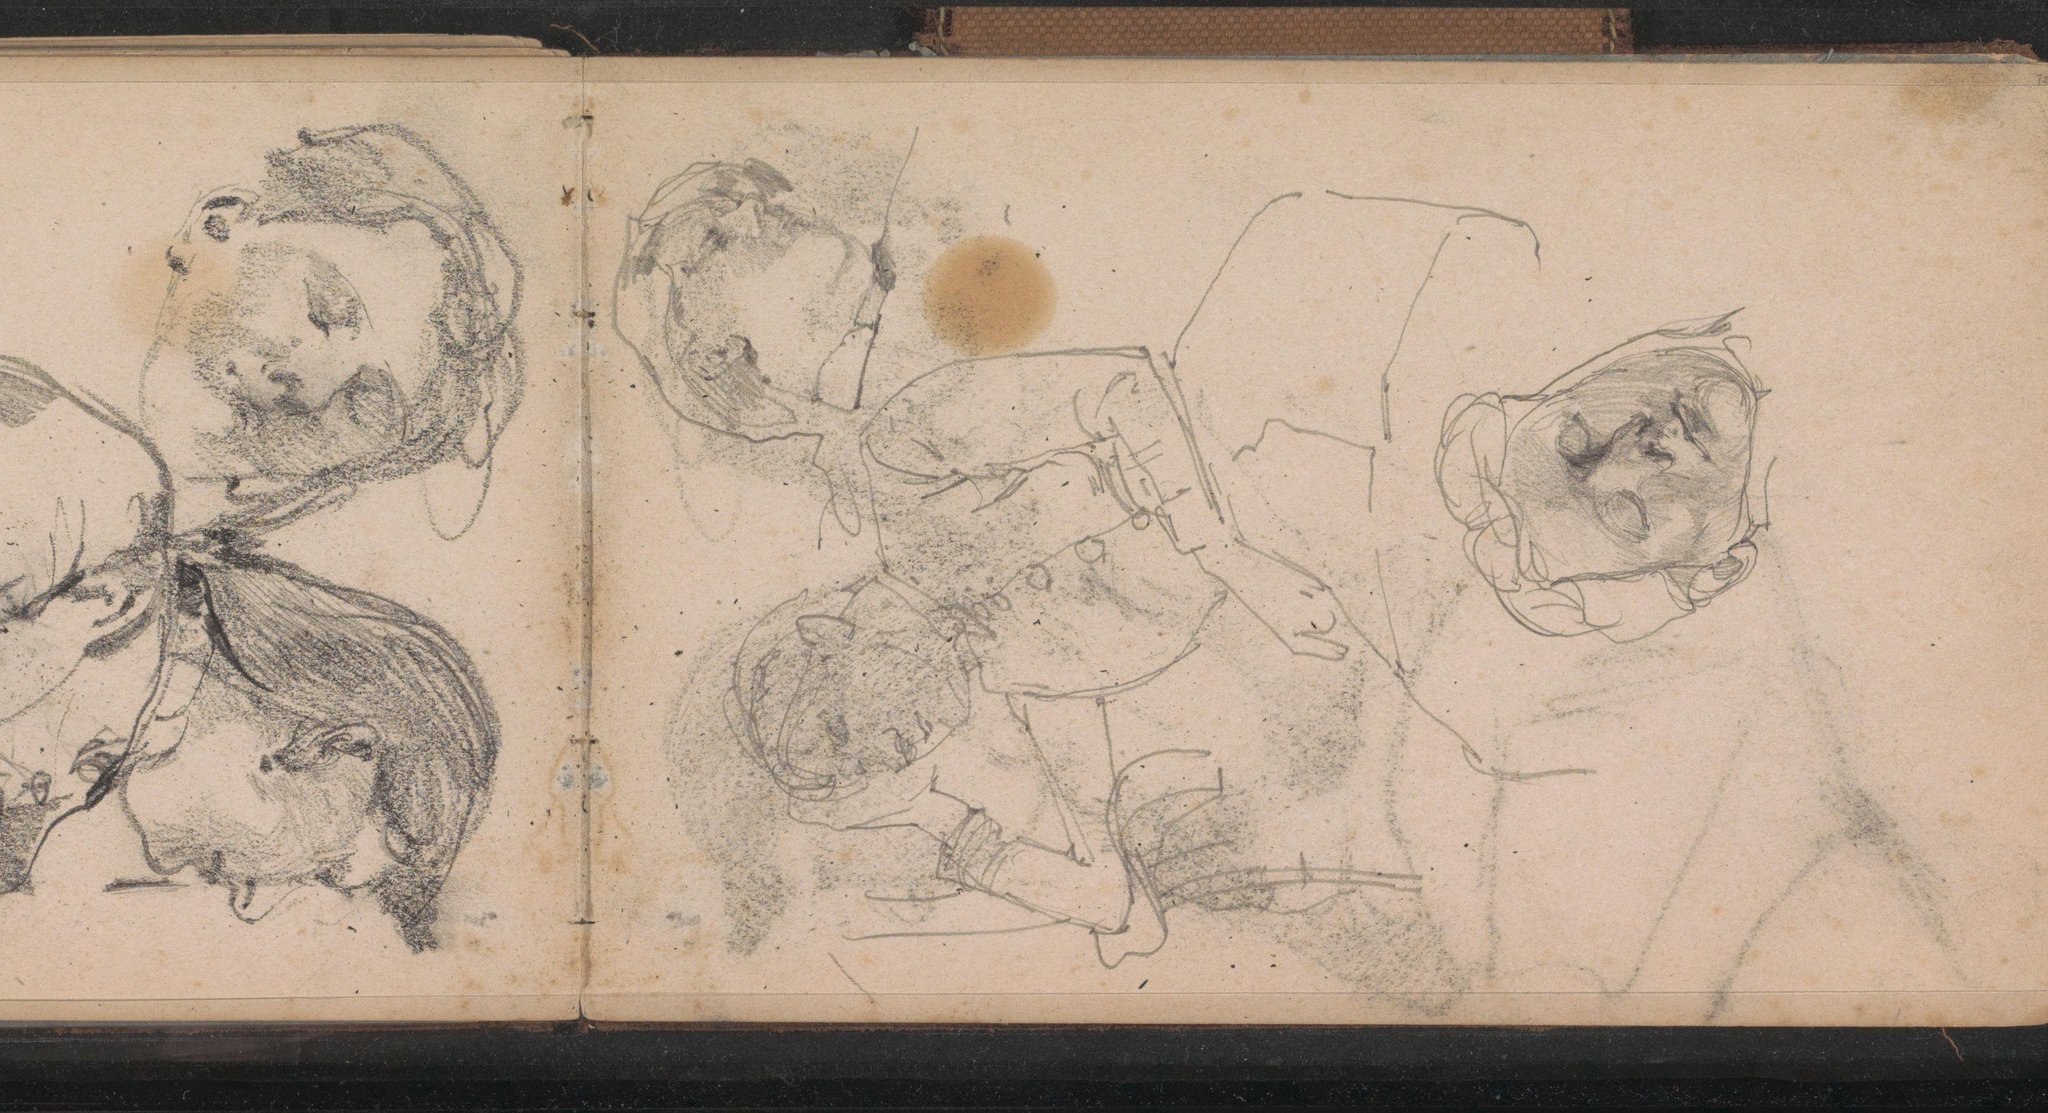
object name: sketchbook leaf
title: Drie figuurstudies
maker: george hendrik breitner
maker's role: draughtsman, painter, print maker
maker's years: 1857-1923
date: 1880-1882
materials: paper, pencil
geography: scheveningen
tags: head (human), adult woman, mind, spirit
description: De figuren slapen mogelijk. Pagina 72 uit een schetsboek met 37 bladen.